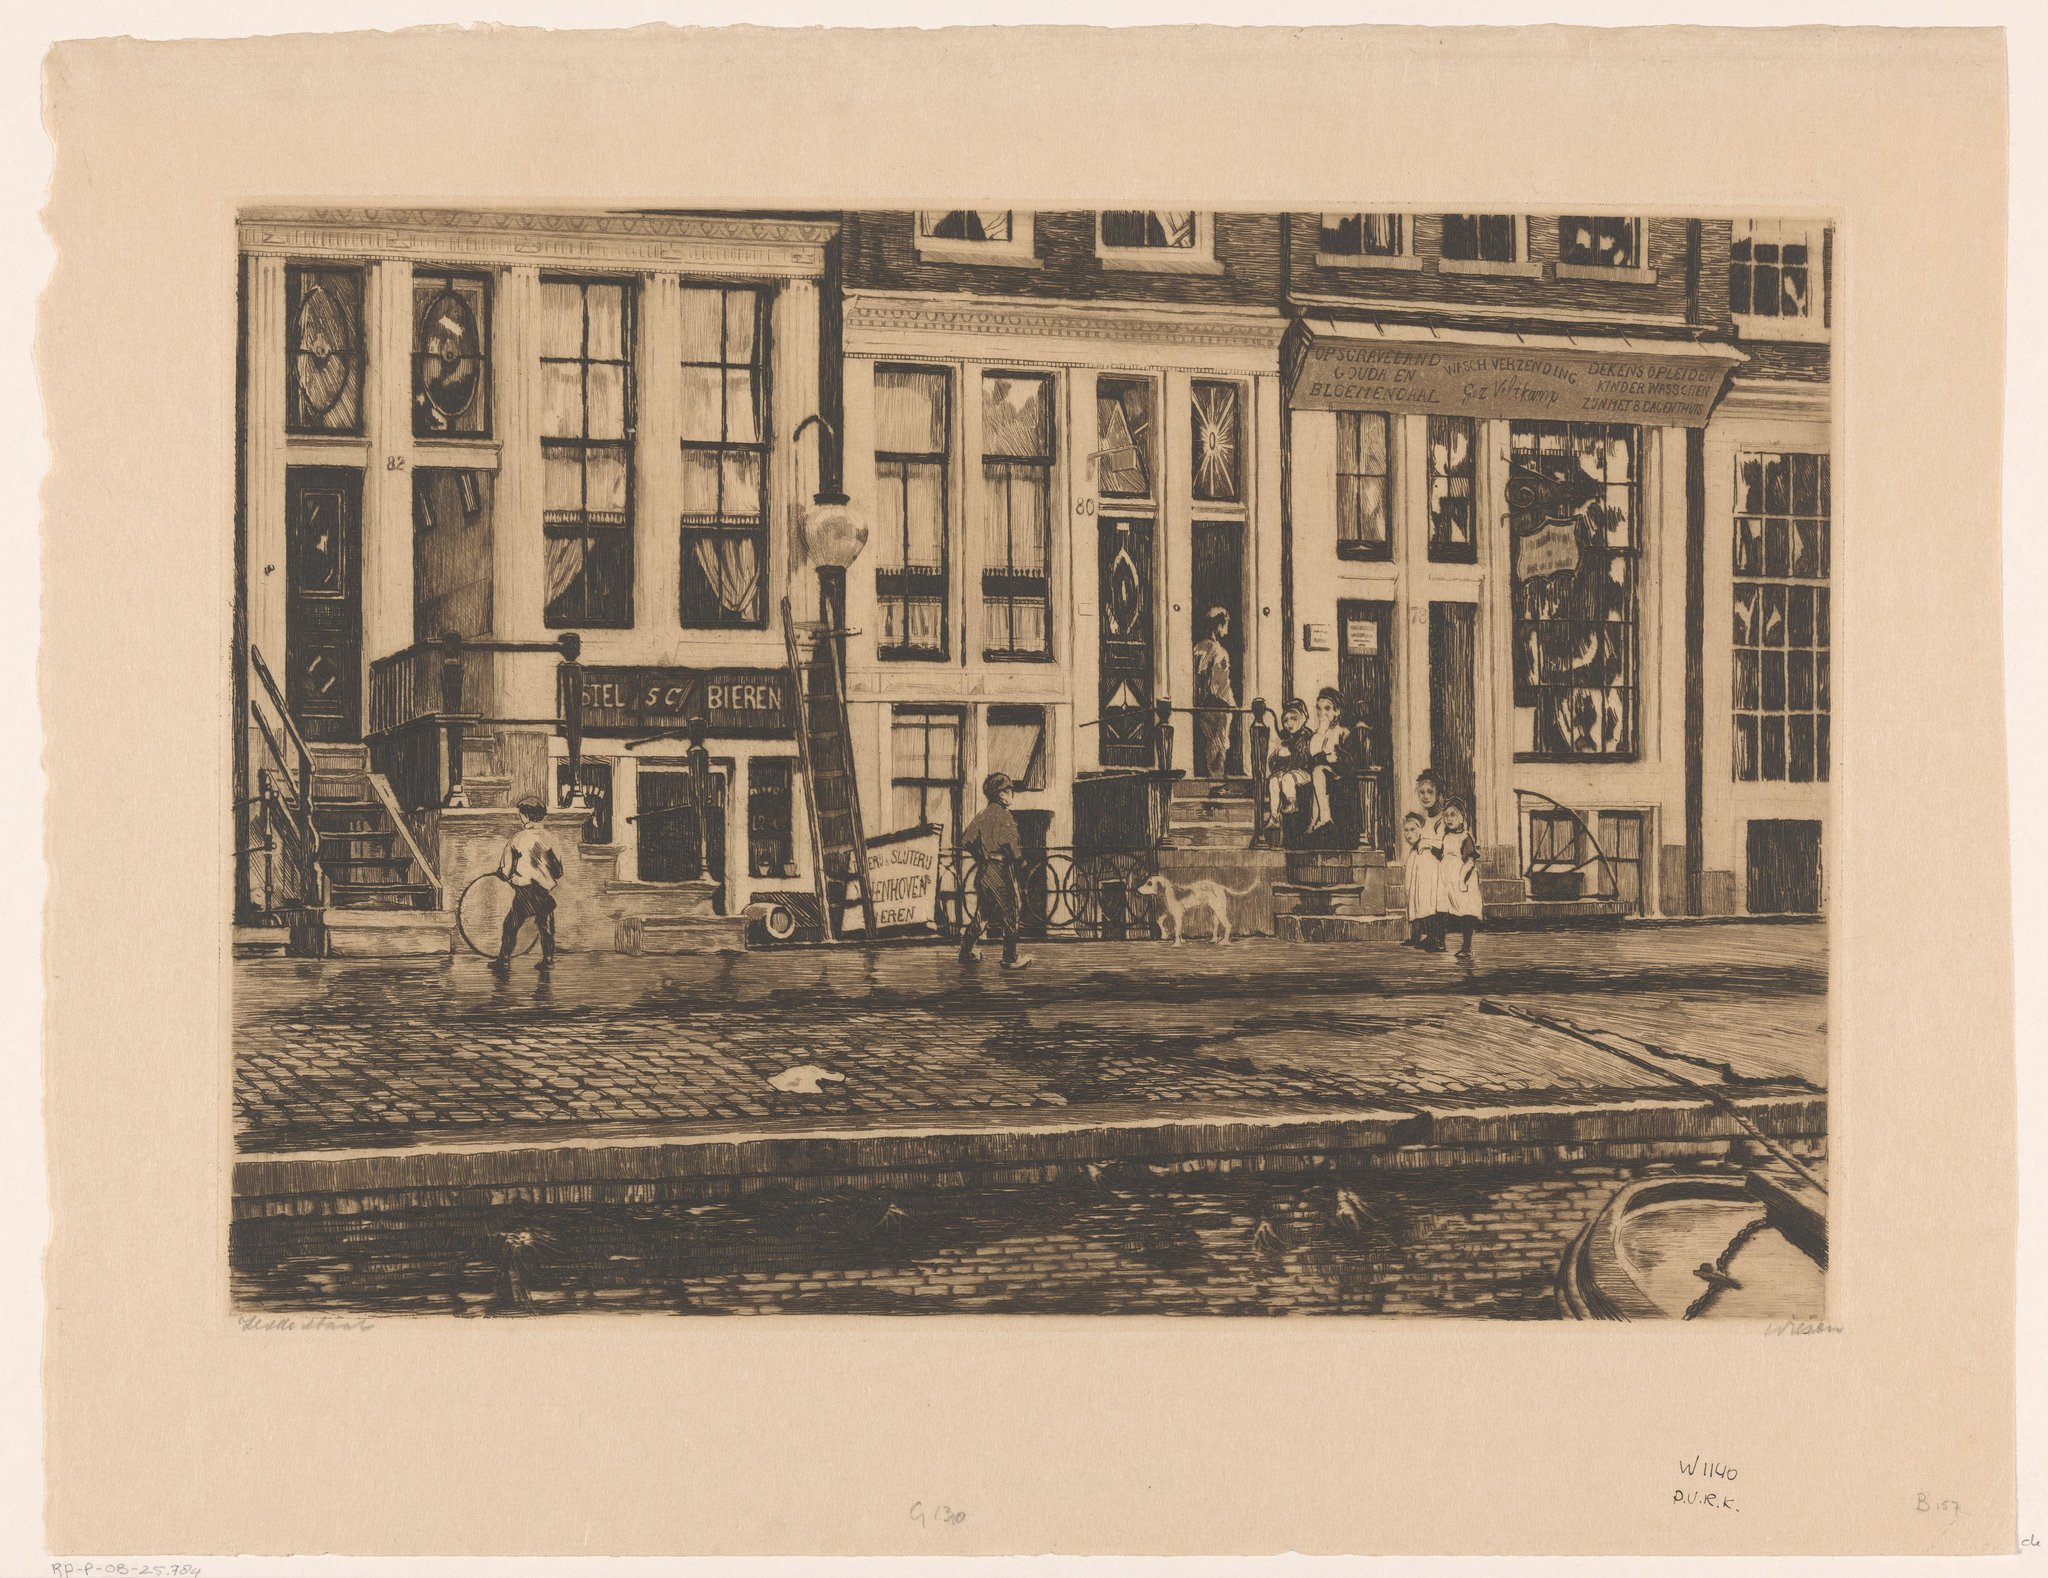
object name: print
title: Oude Waal met de wasinrichting van de gezusters Veltkamp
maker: willem witsen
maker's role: draughtsman, painter, print maker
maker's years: 1860-1923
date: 1912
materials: paper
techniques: aquatint, etching, intaglio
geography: amsterdam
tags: window, child, door, the usual house or row of houses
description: Gezien vanaf de Waalseilandsgracht. Tegenwoordig nummer 32, 33, 34 en gedeeltelijk 35. Op nummer 34 hadden de gezusters Veltkamp een wasinrichting.